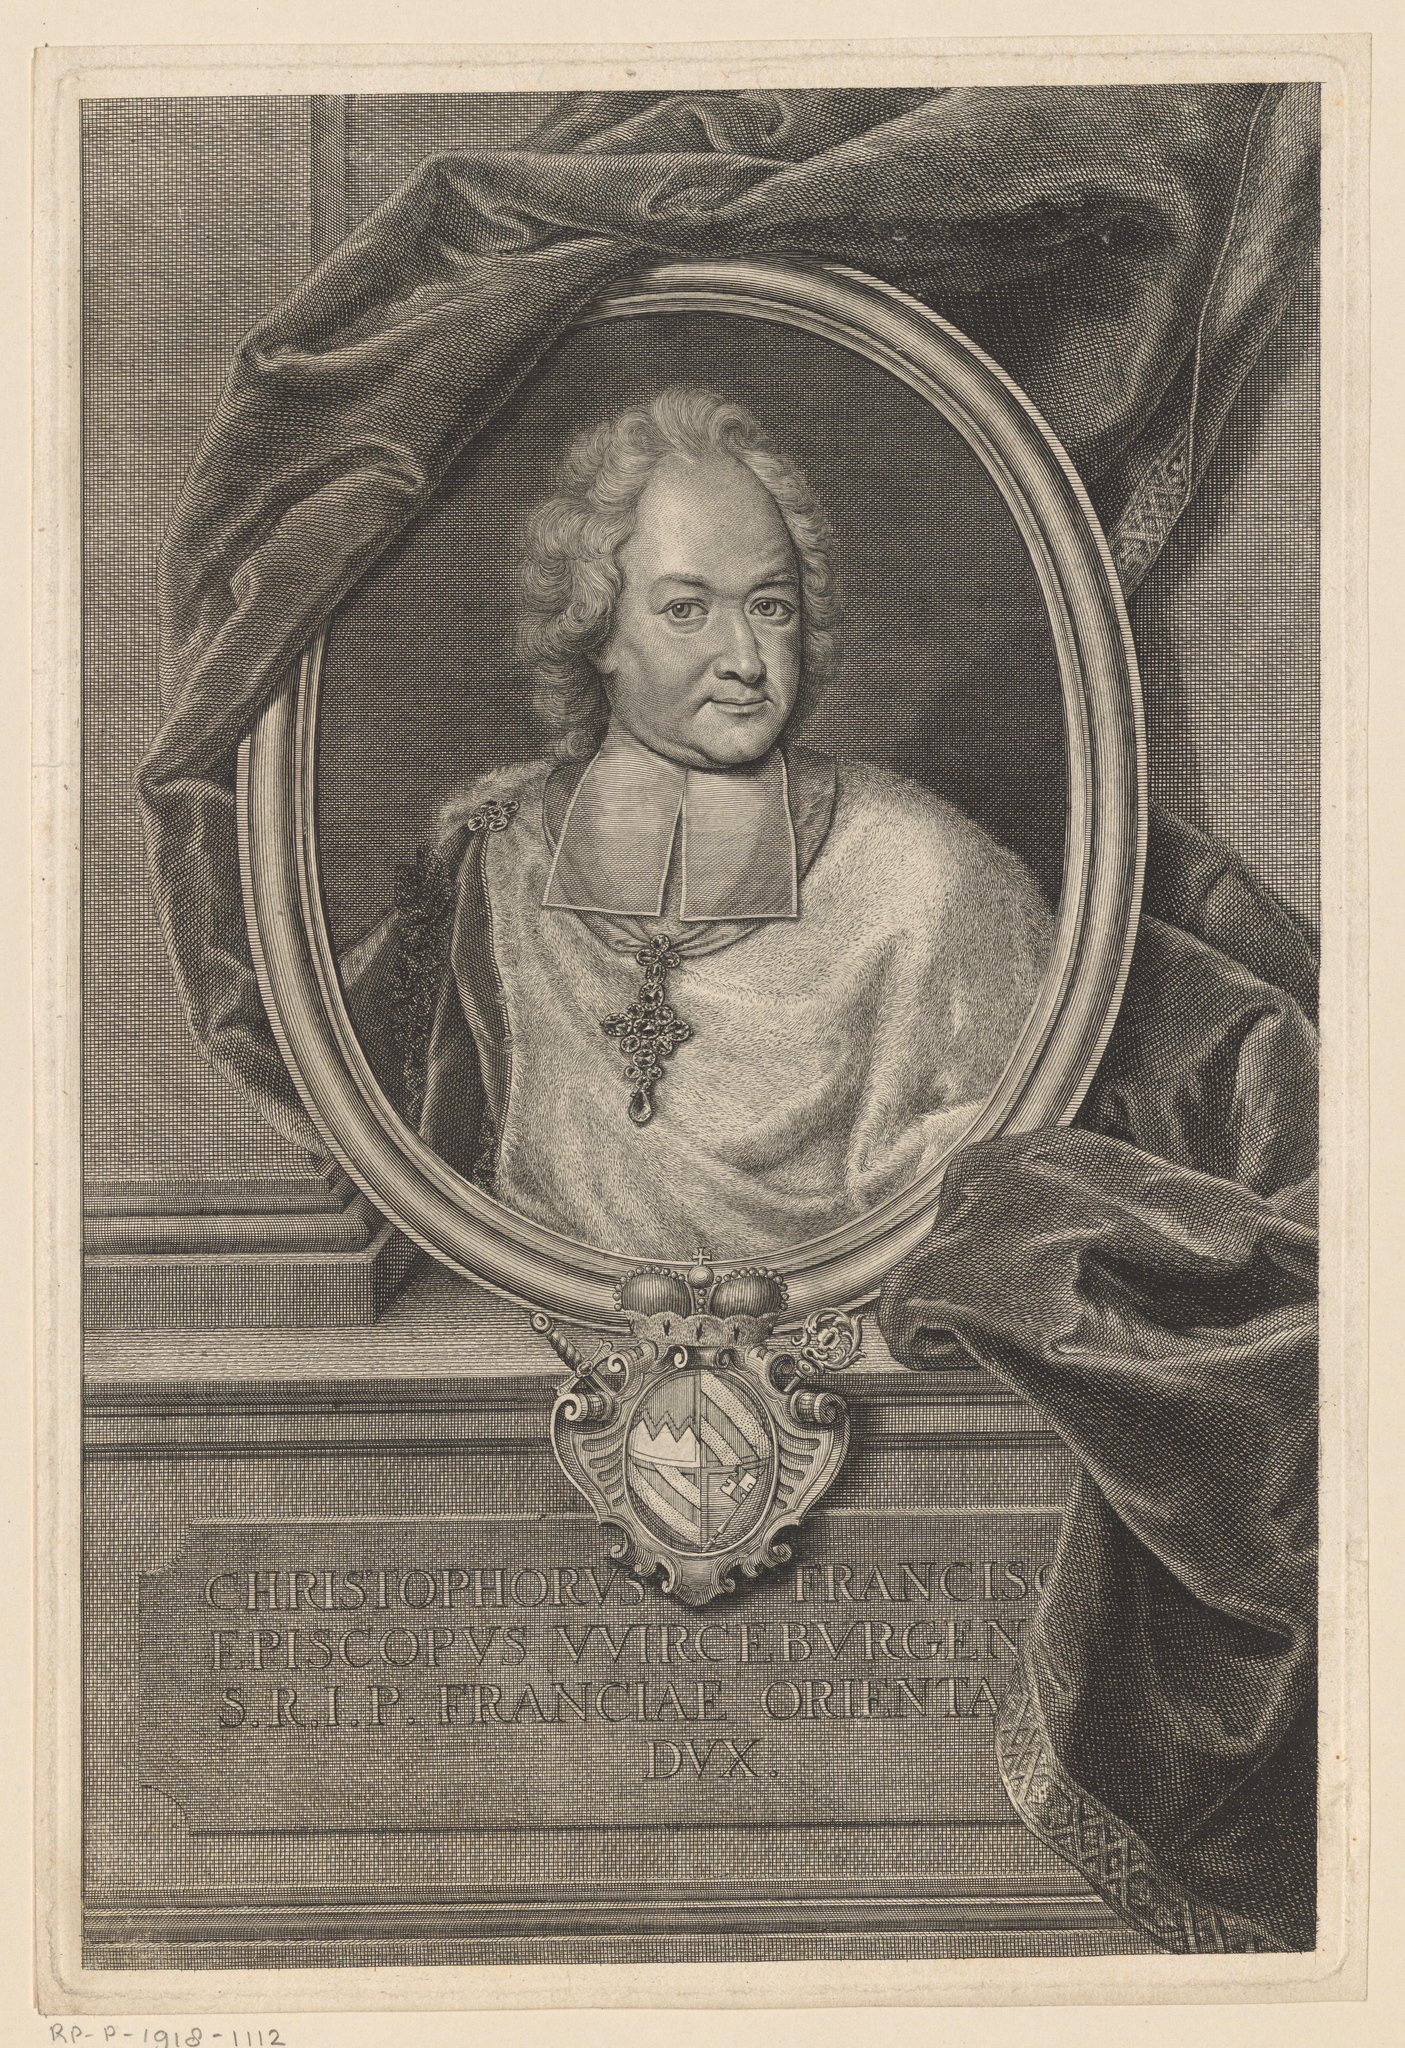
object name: print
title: Portret van Christoph Franz von Hutten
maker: Anonymous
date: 1724-1749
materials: paper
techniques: engraving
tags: archbishop, bishop, etc. (roman catholic), historical persons, armorial bearing, heraldry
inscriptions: collector's mark: Lugt 2233